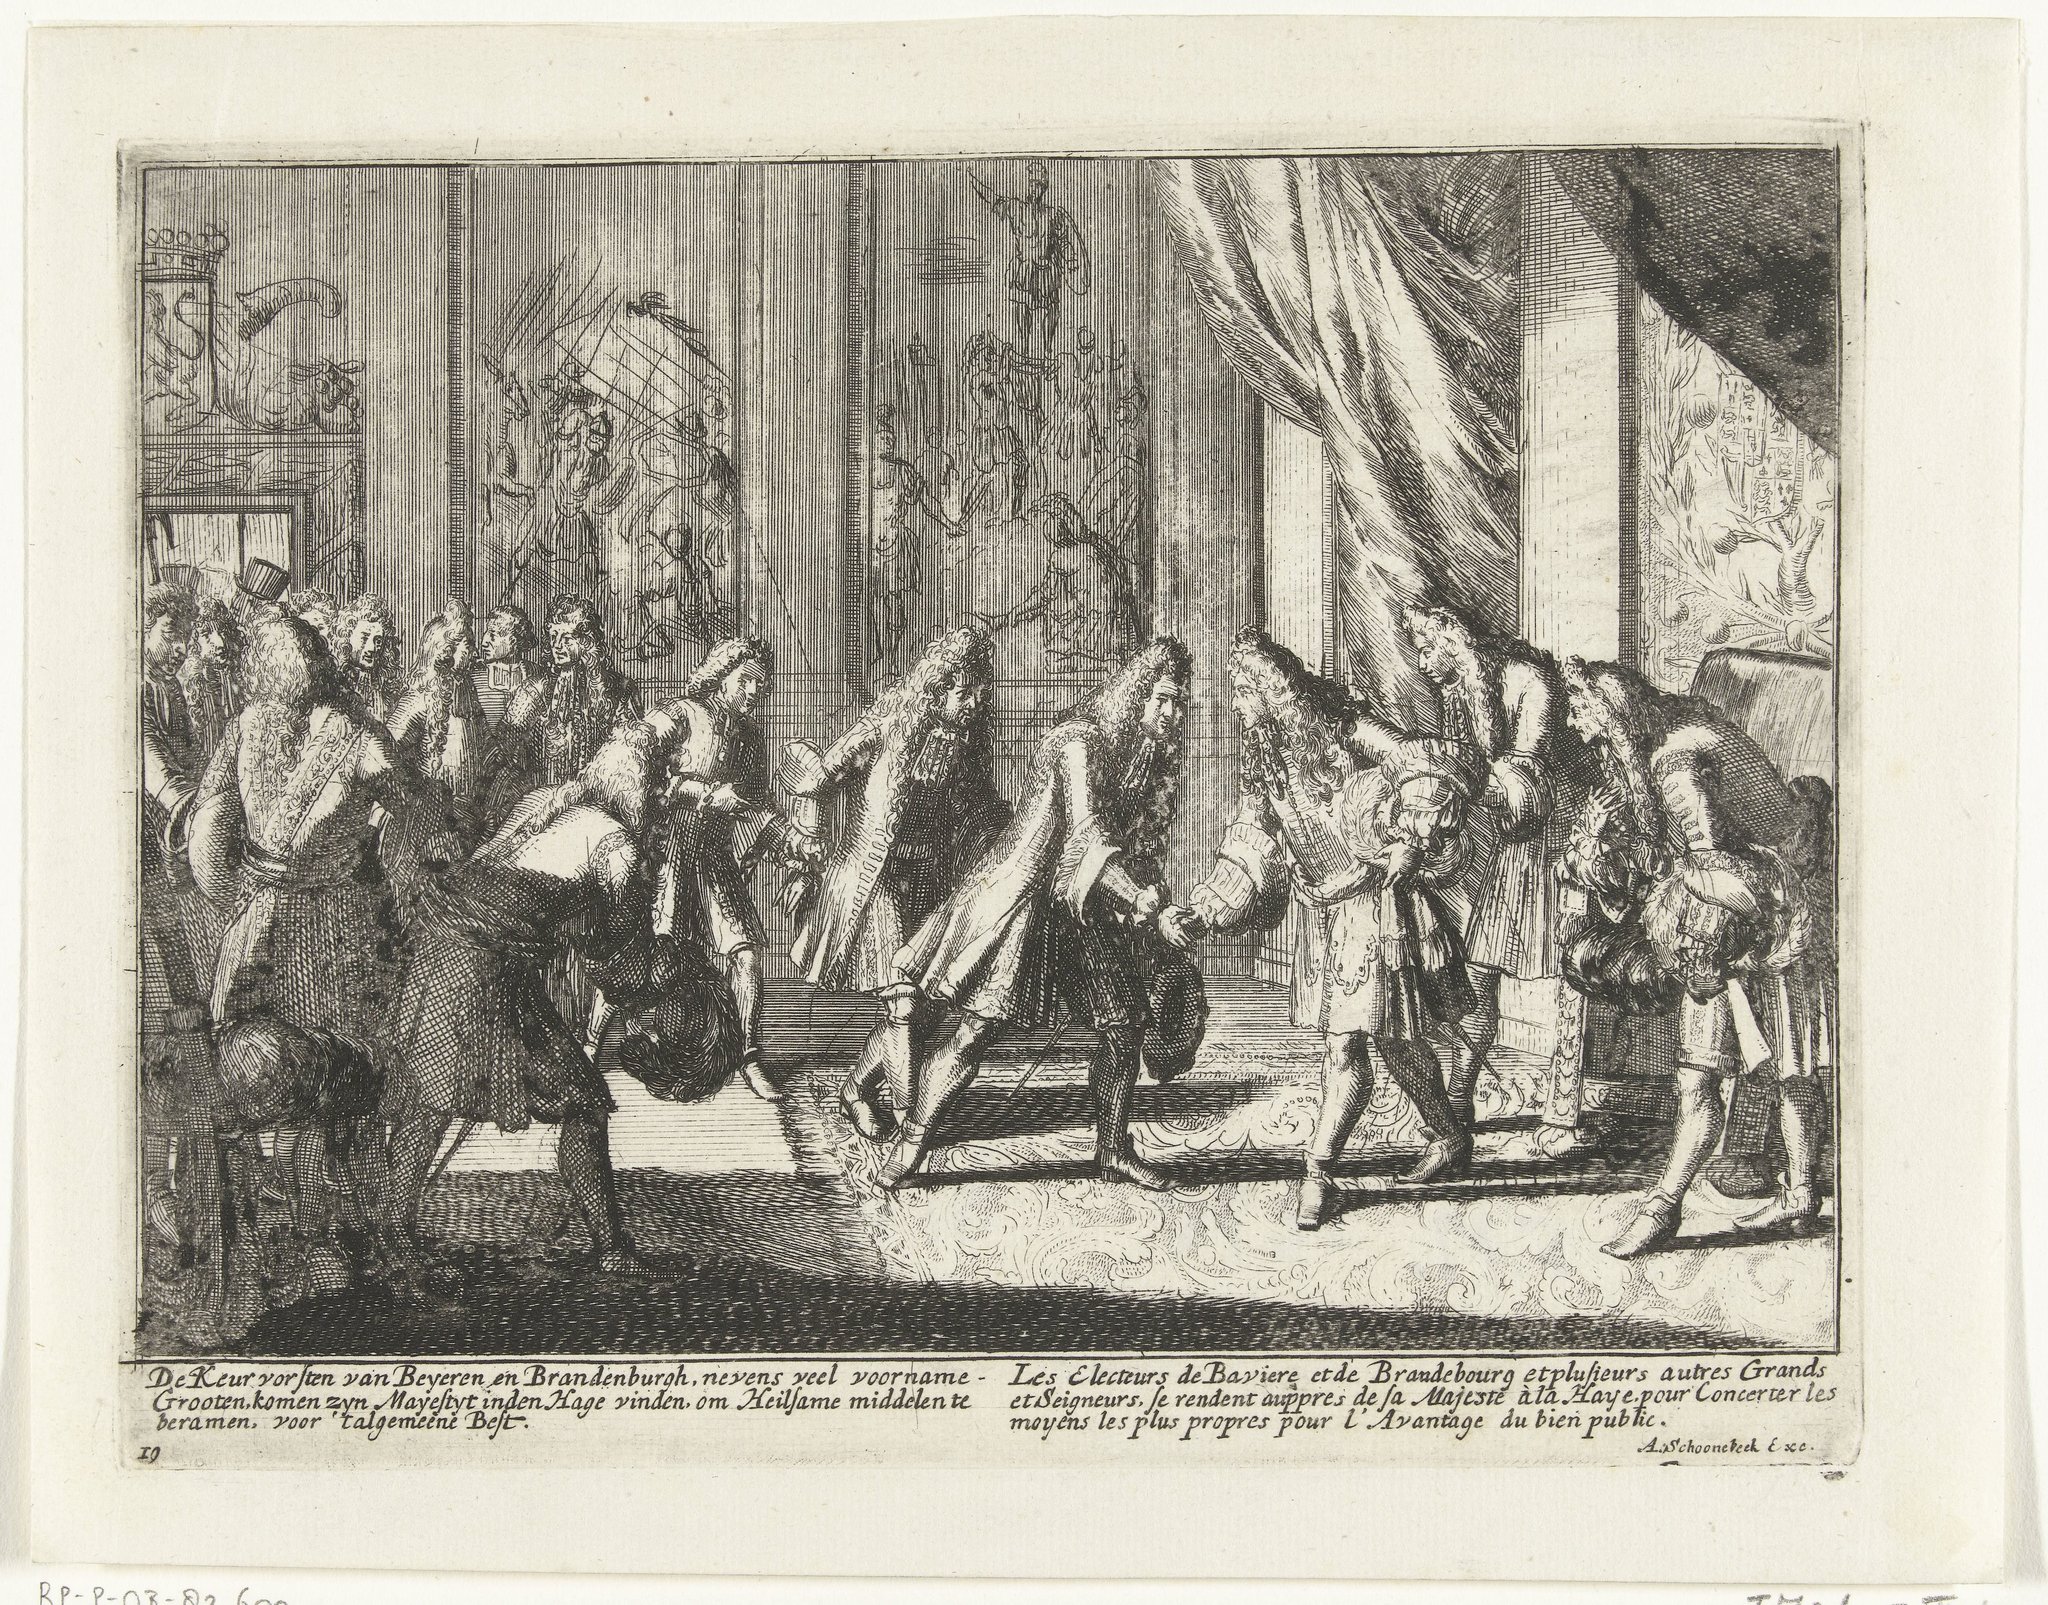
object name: print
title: De keurvorsten van Beieren en van Brandenburg op bezoek bij koning Willem III, 1691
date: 1691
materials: paper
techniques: etching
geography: amsterdam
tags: william iii (prince of orange and king of england, scotland, and ireland), shaking hands, 'dextrarum junctio'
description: De keurvorsten van Beieren en van Brandenburg op bezoek bij koning Willem III, 1691. De vorsten begroeten elkaar en schudden elkaar de hand. Plaat nr. 19 in de serie 'Engelands schouwtoneel' over de oorlog tussen Willem III en Jacobus II in de jaren 1690-1691 na de Glorious Revolution, (derde deel). Met onderschriften in het Nederlands en Frans.